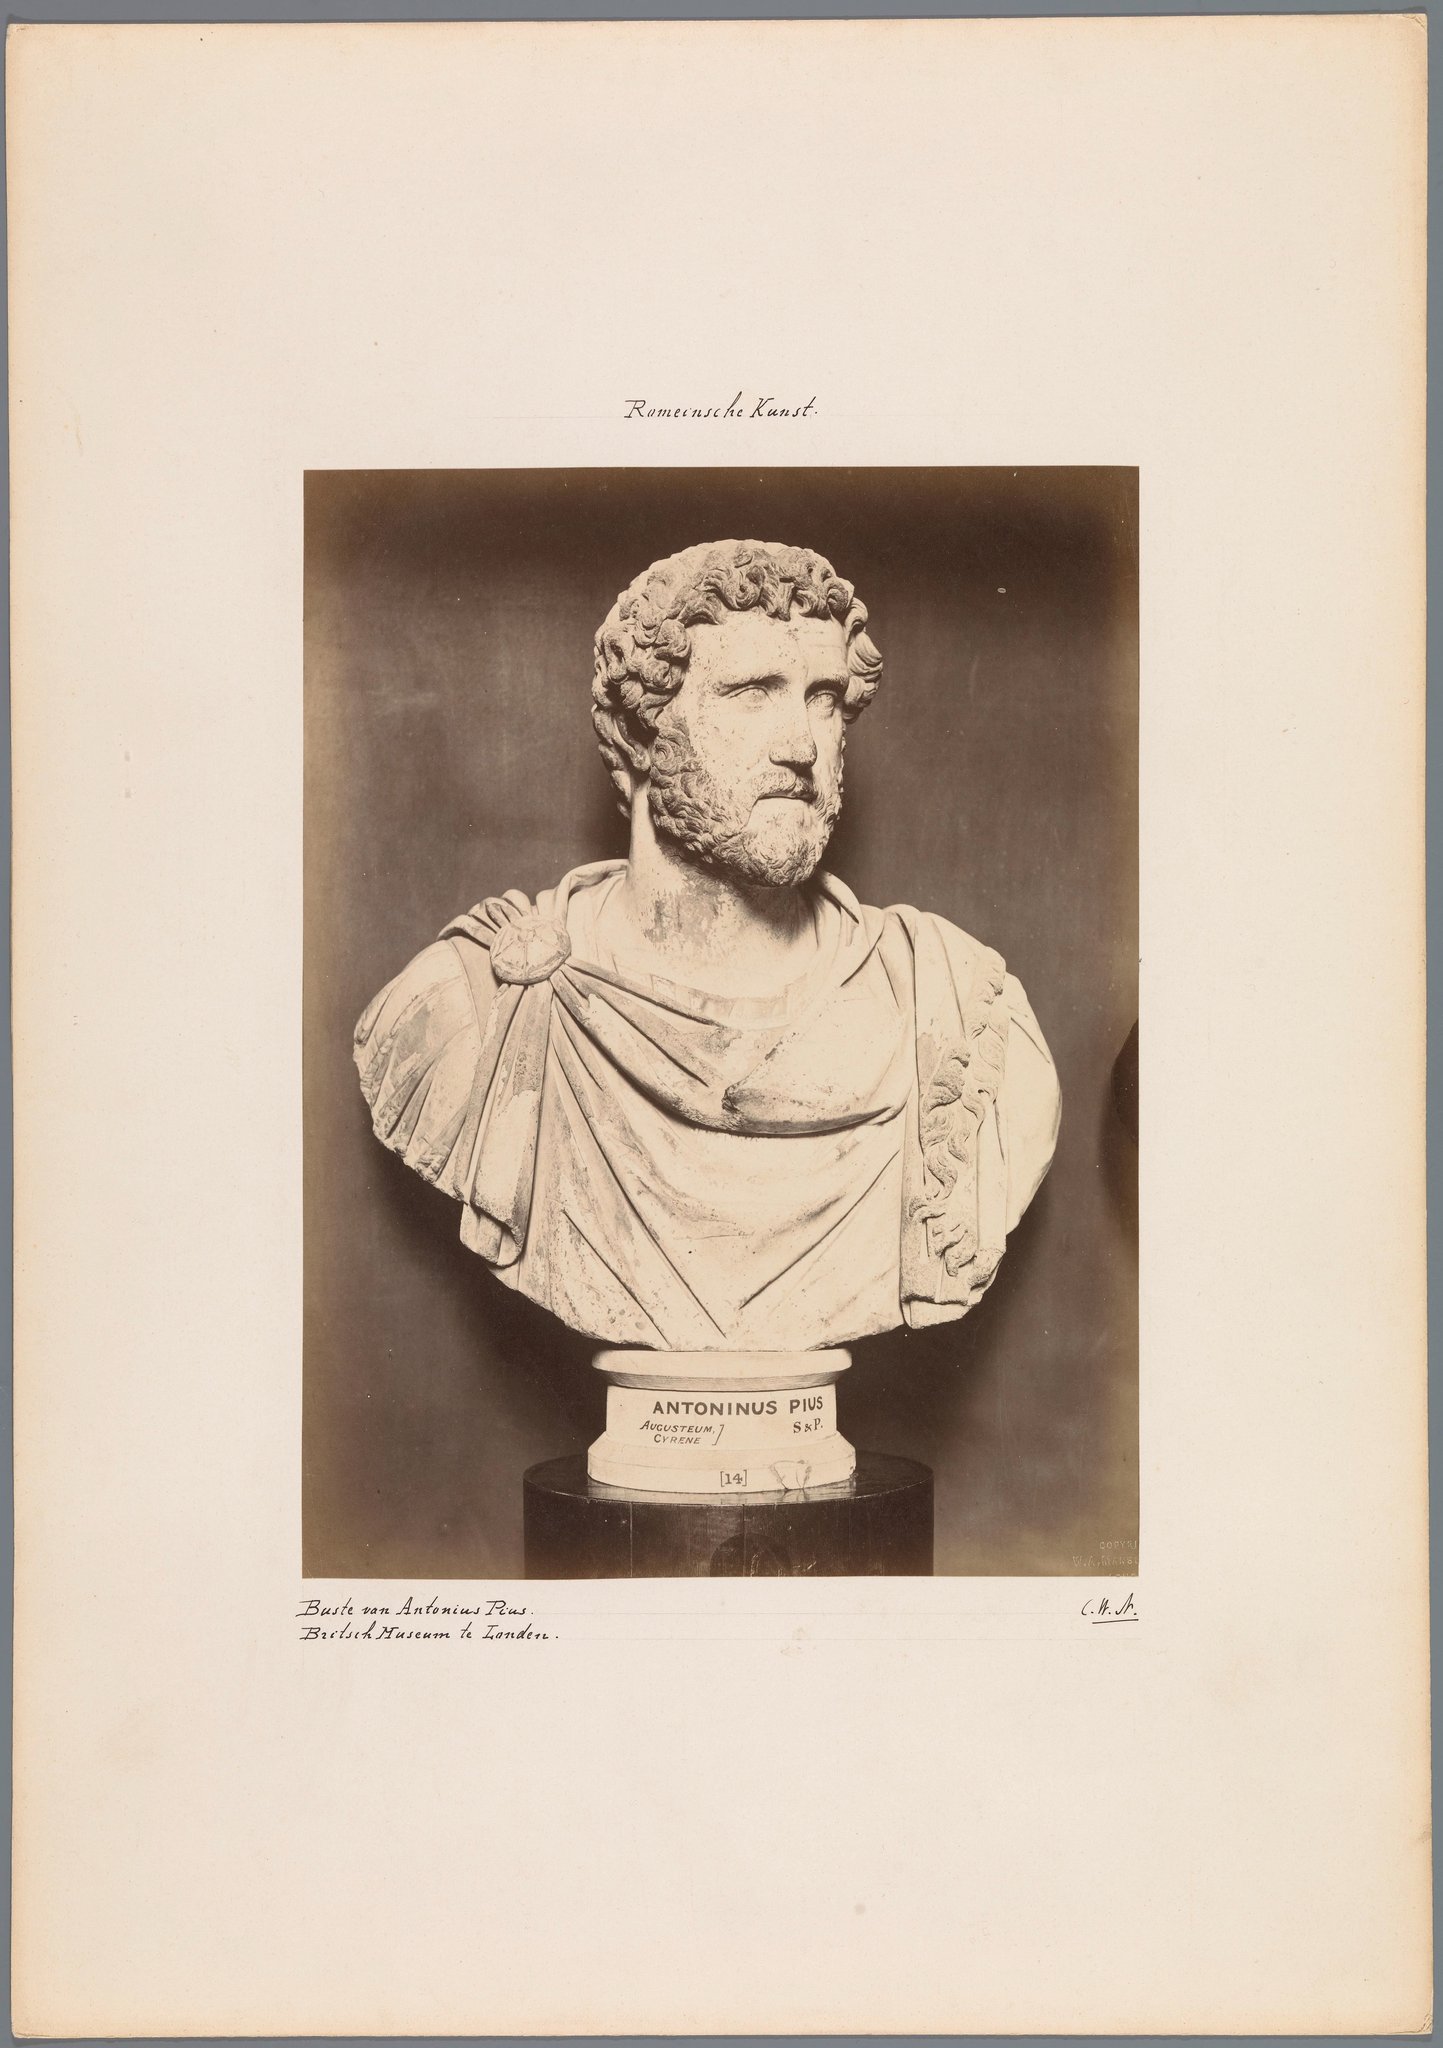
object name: photograph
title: Buste van Antoninus Pius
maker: Anonymous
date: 1875-1900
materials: cardboard, photographic support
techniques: albumen print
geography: europe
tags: male persons from classical history (+ head, bust, etc.), piece of sculpture, reproduction of a piece of sculpture, europe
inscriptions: collector's mark: ‘KUNSTNIJVERHEIDSCHOOL QUELLINUS AMSTERDAM FRANS HALSSTRAAT 14.’, inscription: ‘C.W.N.’, inscription: ‘Romeische Kunst.’, collector's mark: ‘INSTITUUT VOOR KUNST-NIJVERHEIDSONDERWIJS GABRIËL METSUSTRAAT No. 16 AMSTERDAM’, name: ‘COPYR W.A. MANSE’